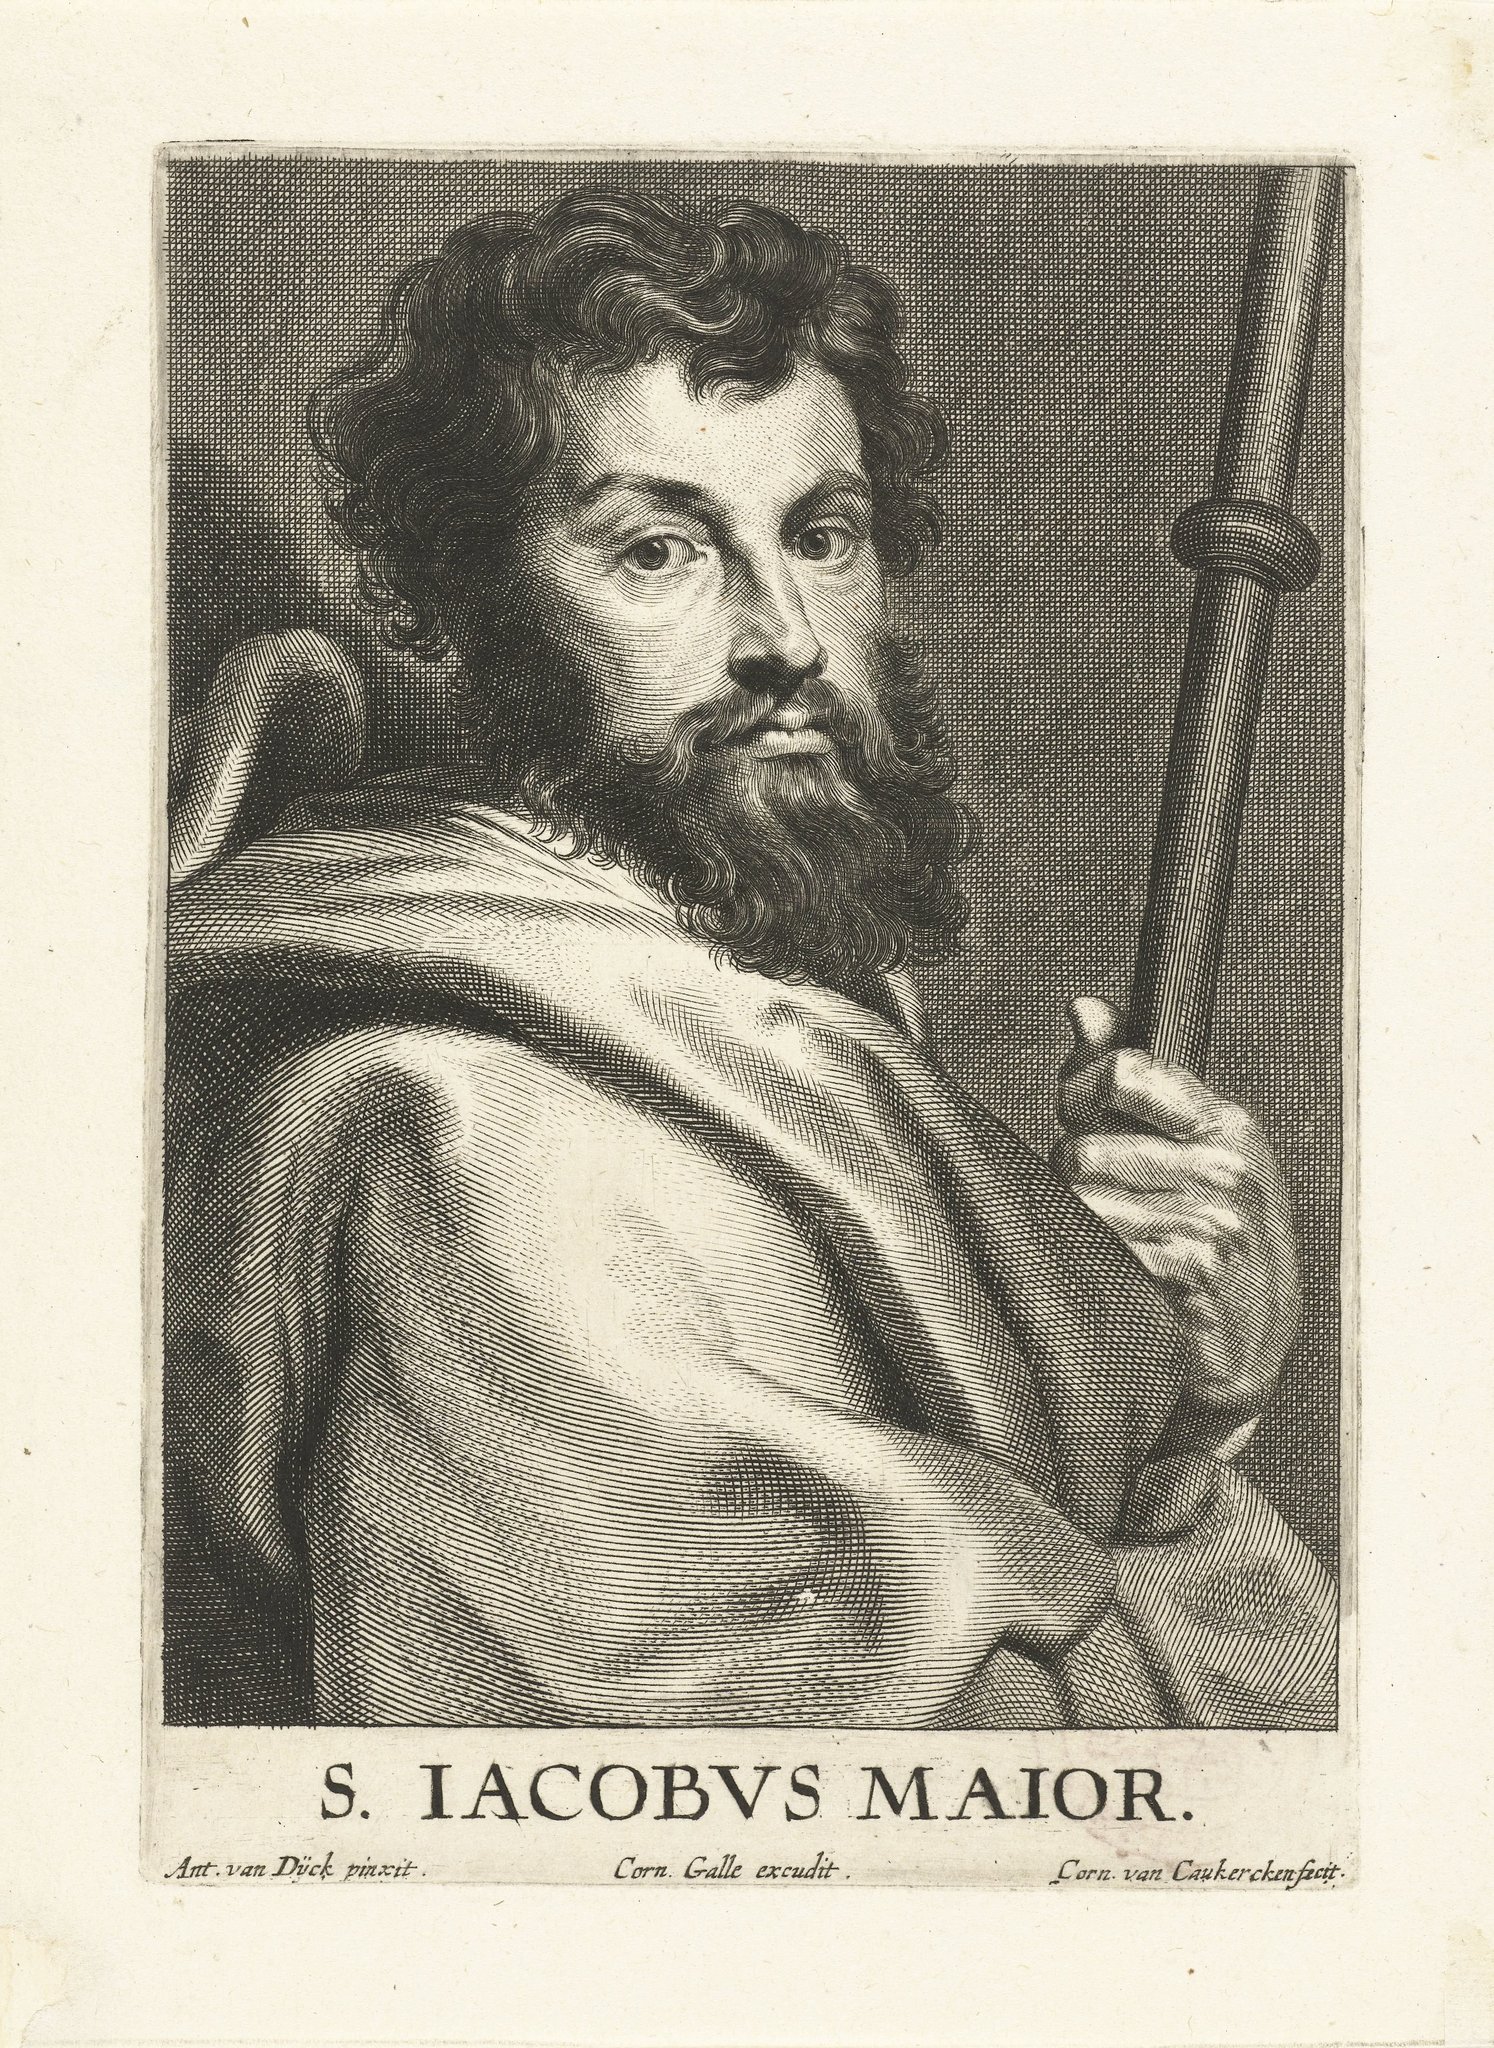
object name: print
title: Christus en de apostelen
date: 1640-1680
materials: paper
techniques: engraving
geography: antwerp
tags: the apostle james the great; possible attributes: book, pilgrim's cloak, hat, shell, staff, and wallet, scroll, sword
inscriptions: collector's mark: Lugt 240